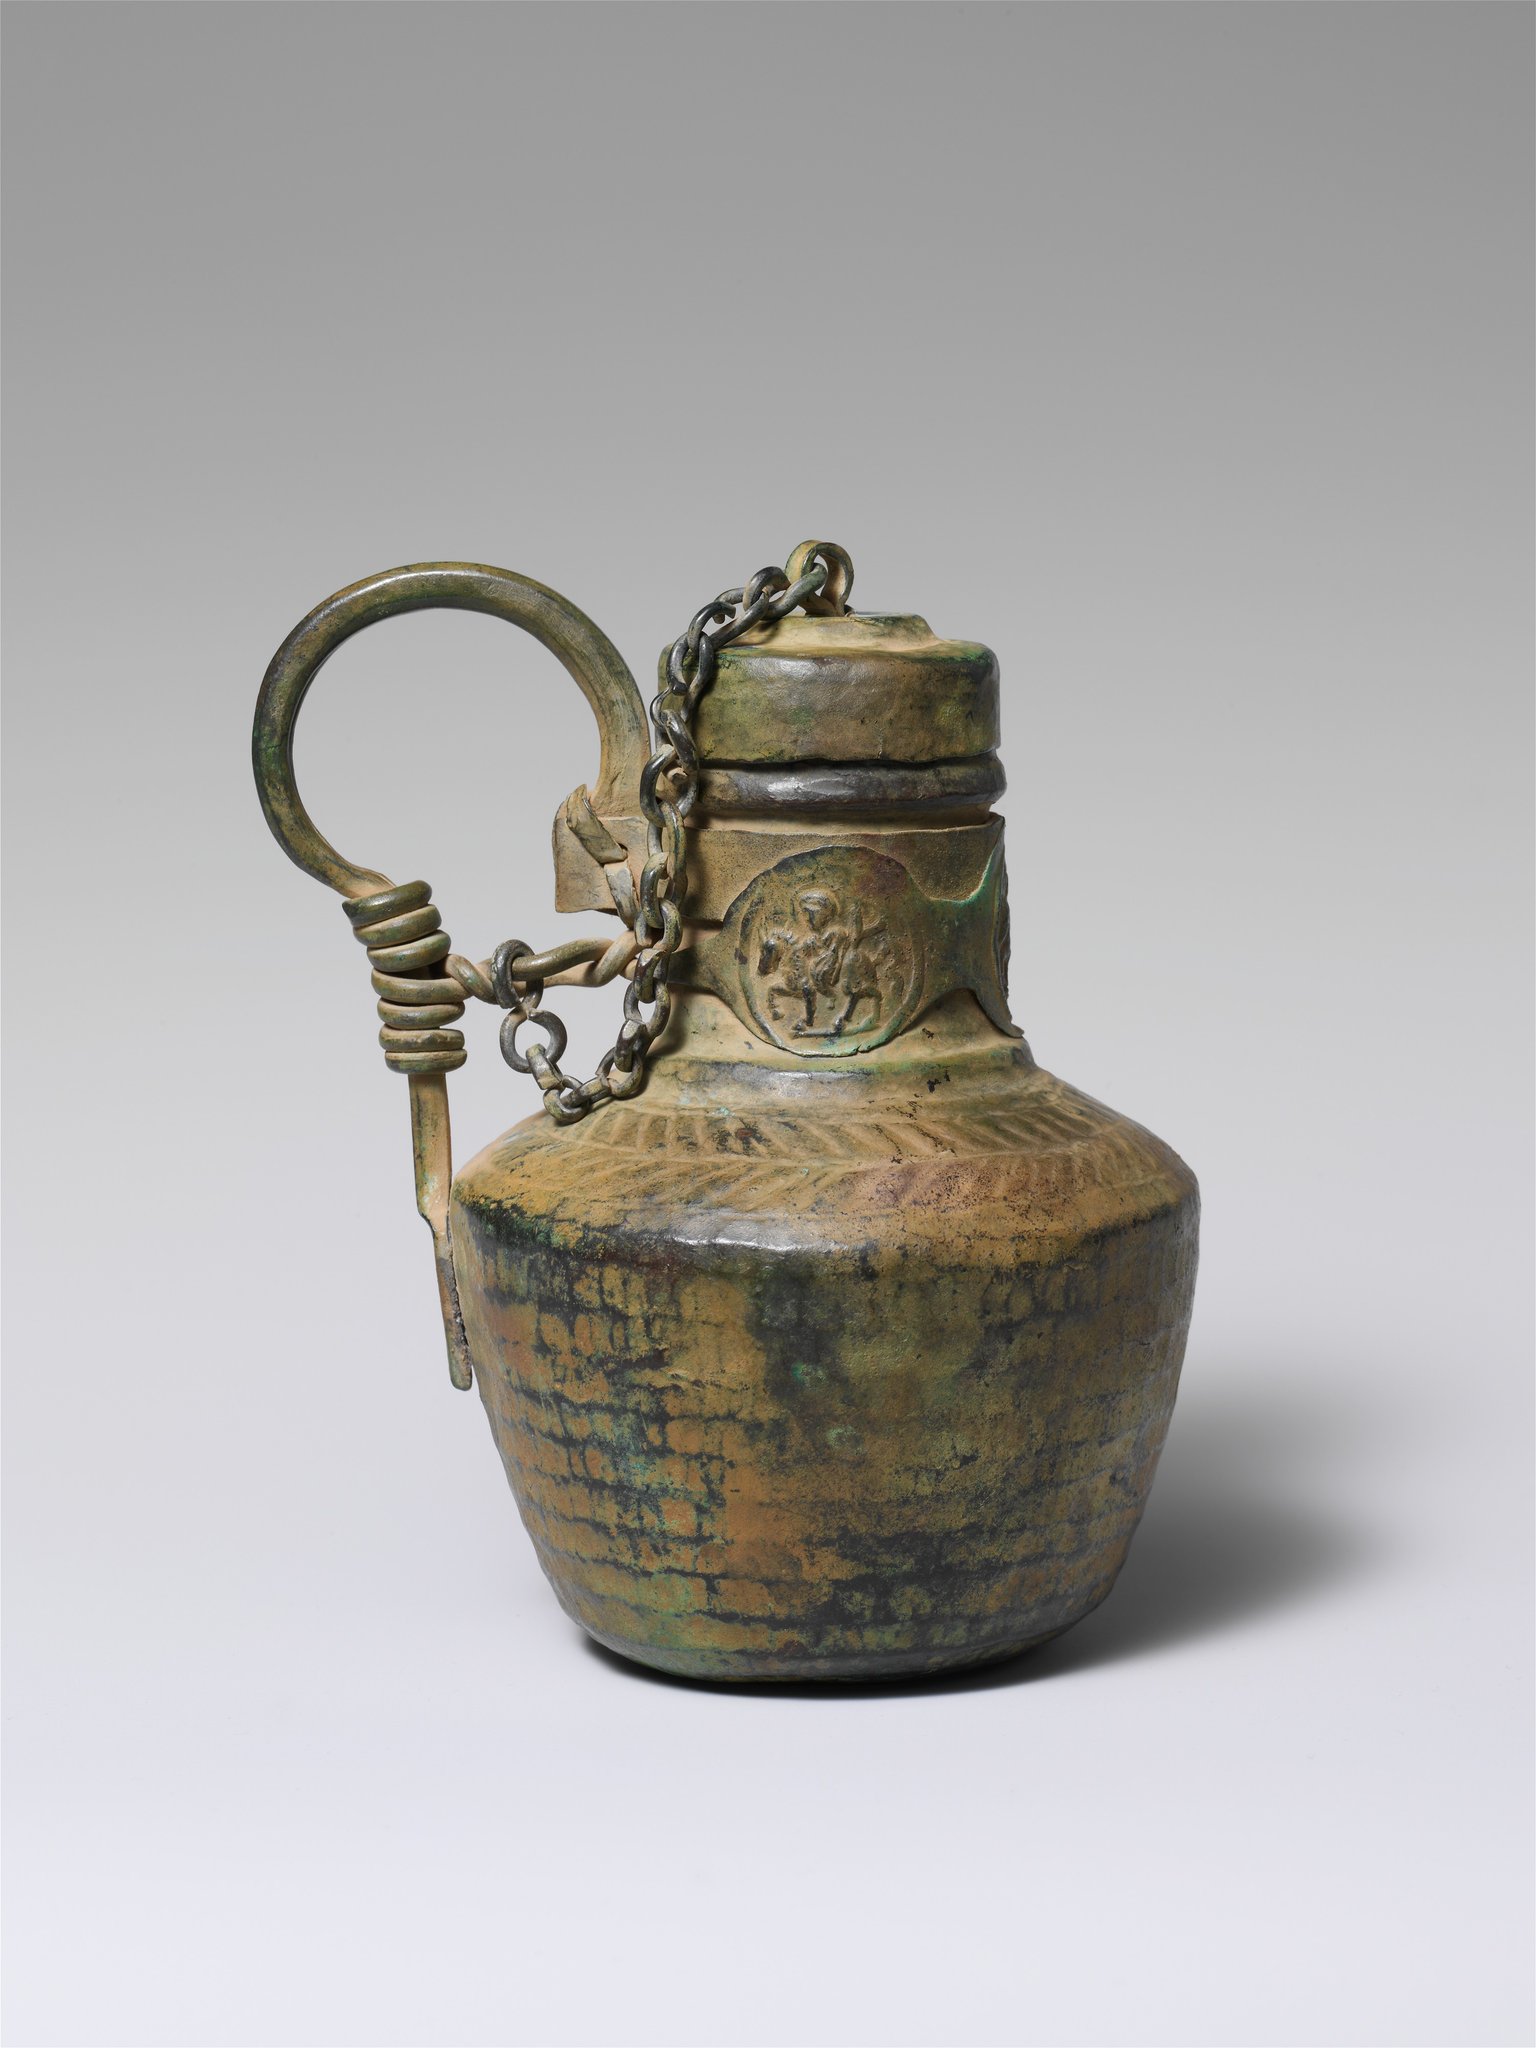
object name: jug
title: Jug with Medallions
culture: byzantine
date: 501-800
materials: copper alloy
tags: animals,medallions